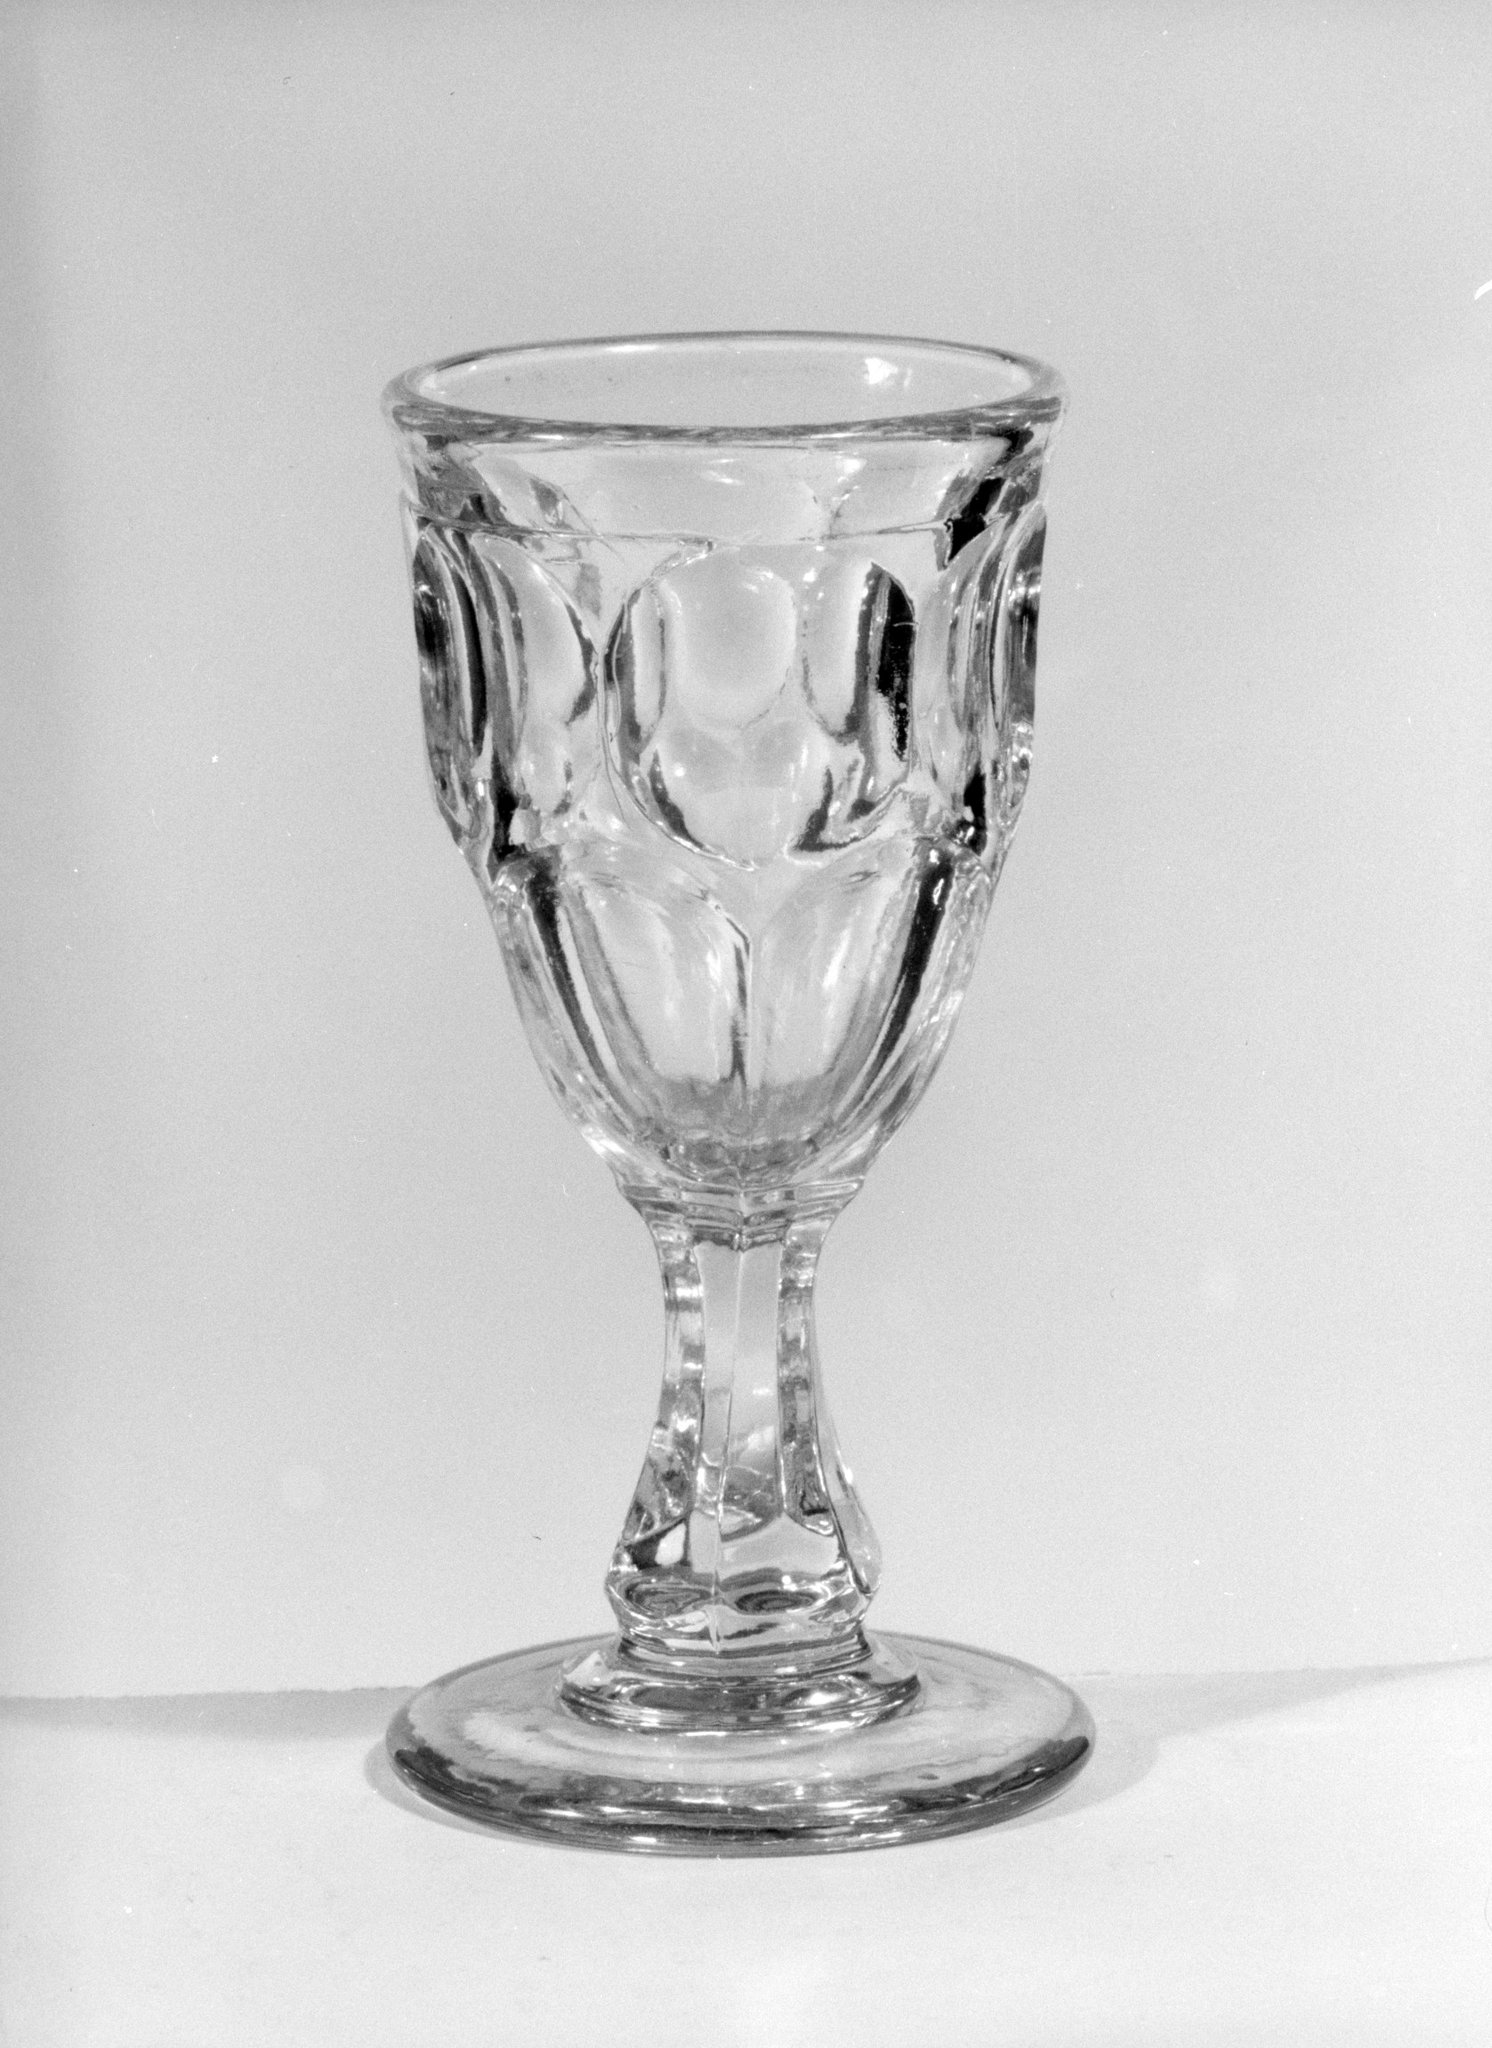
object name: egg cup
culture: american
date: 1830-1870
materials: glass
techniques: pressed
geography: united states